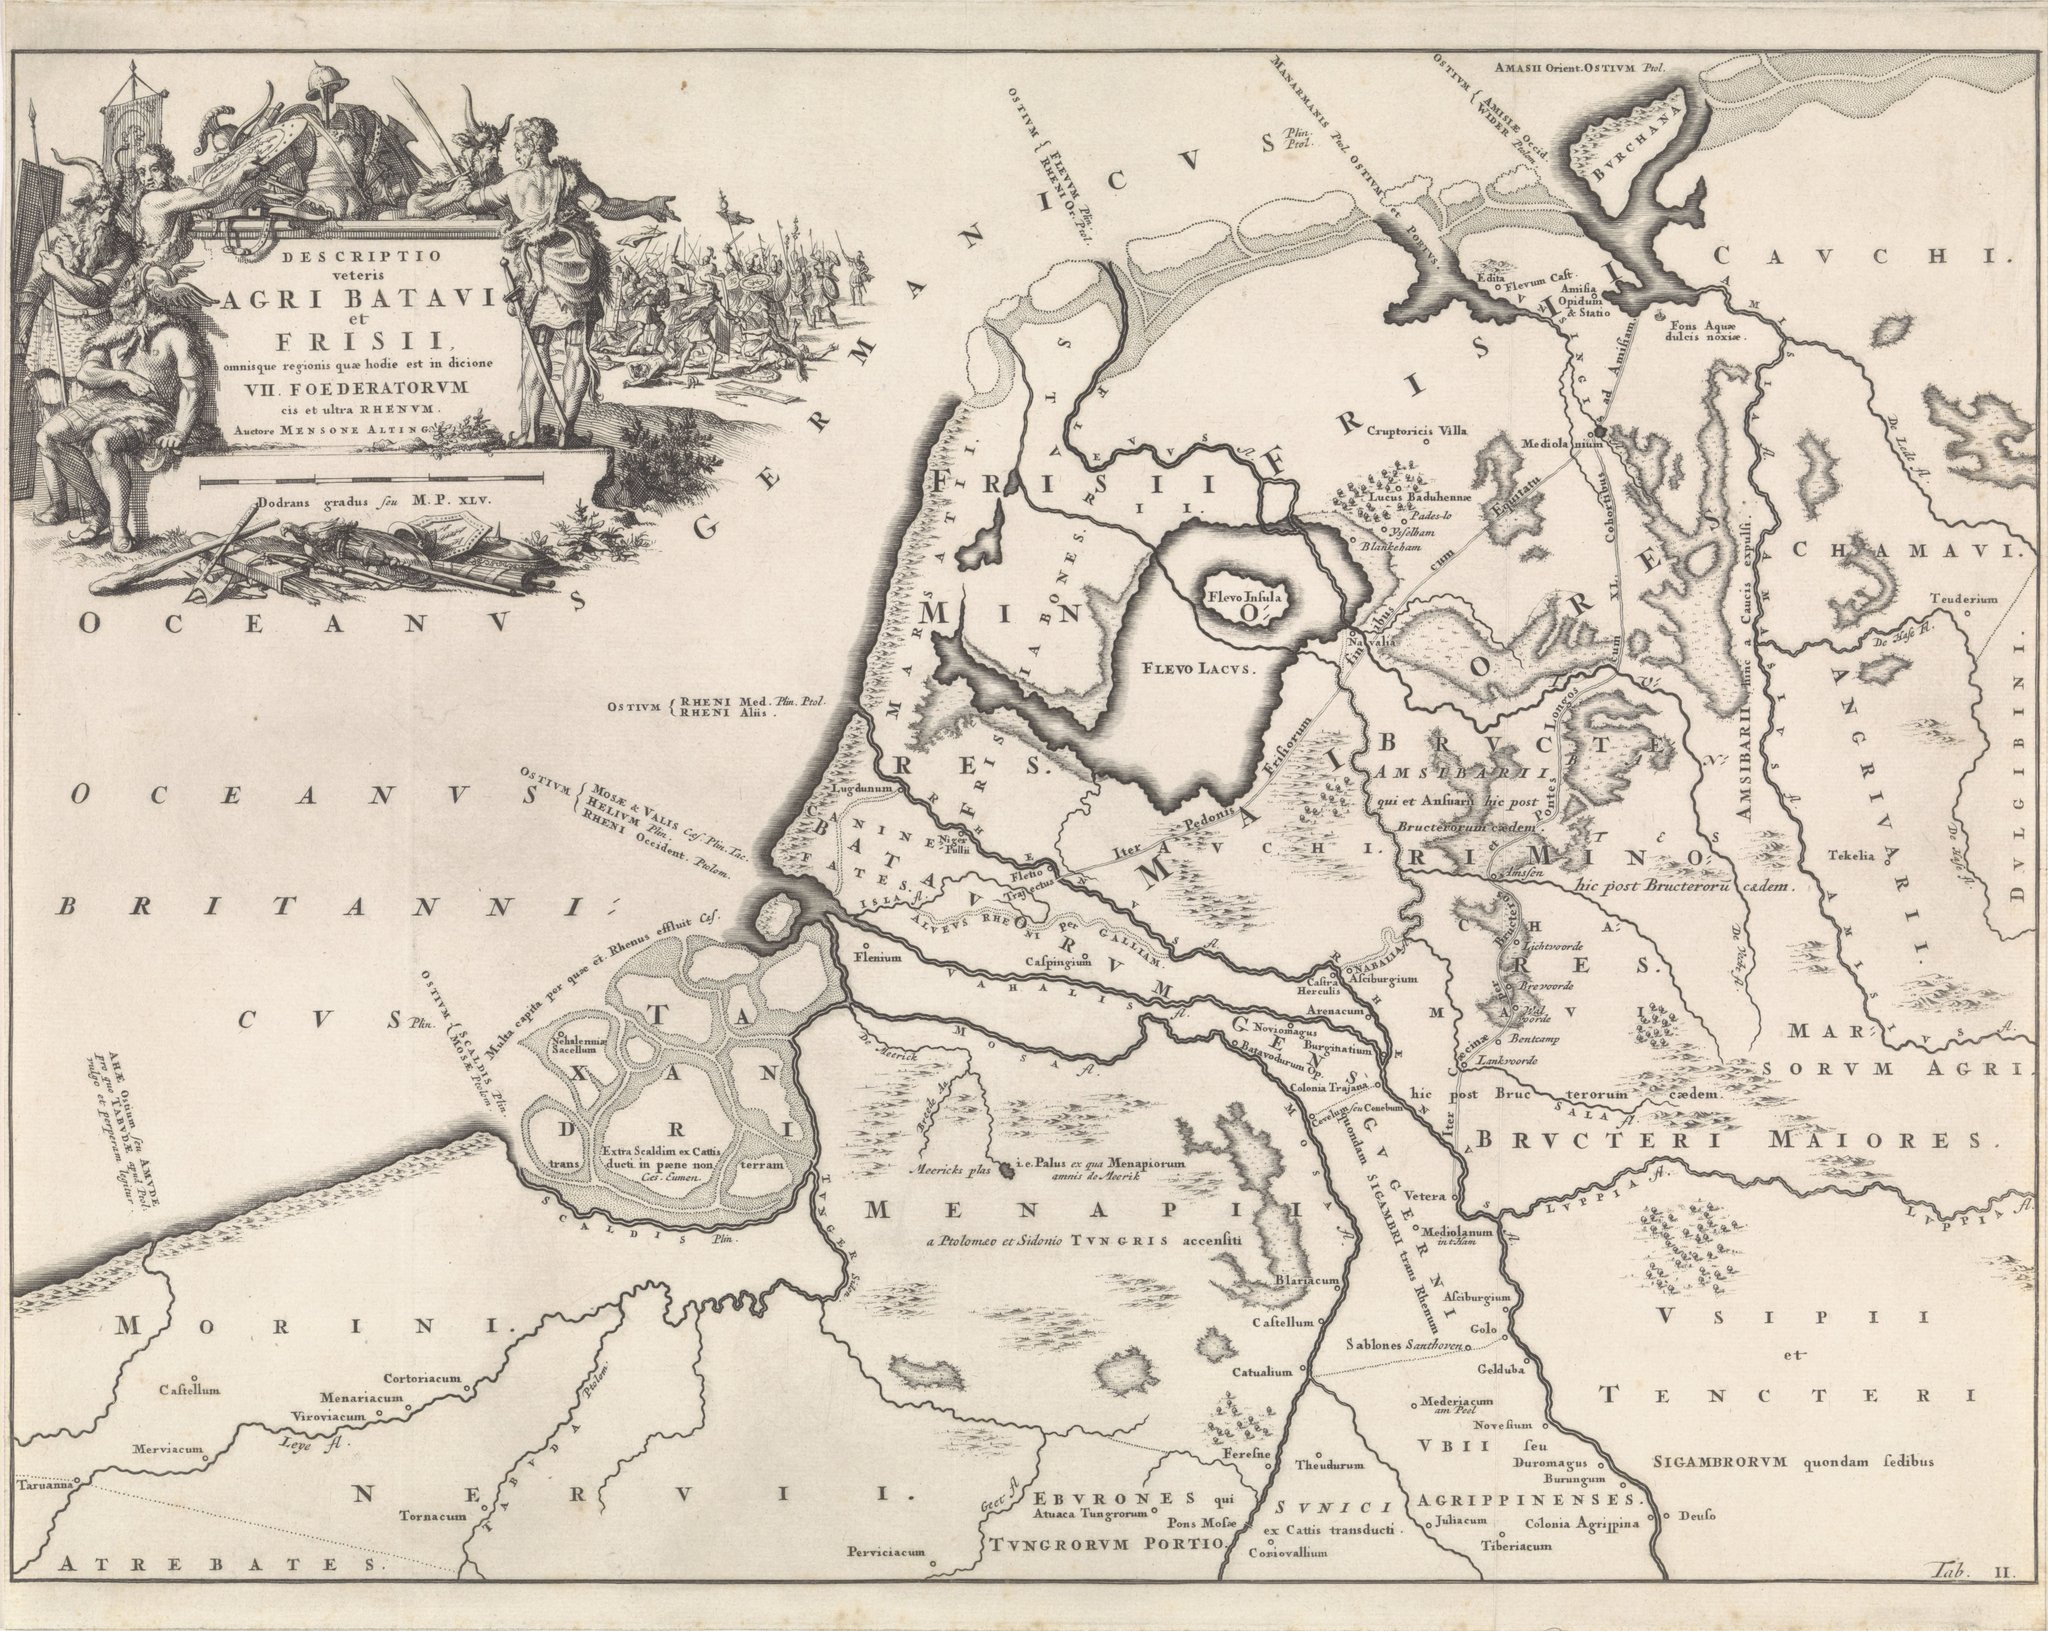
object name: book illustration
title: Historische kaart van Nederland ten tijde van de Bataven en de Friezen II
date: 1697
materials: paper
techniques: etching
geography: amsterdam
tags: maps of separate countries or regions, netherlands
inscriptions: collector's mark: Lugt 2228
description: Kaart afkomstig uit: Alting, Menso. Descriptio, secundum antiquos, agri Batavi & Frisii. 2 delen. Amsterdam: Henricus Wetstein, 1697, dl. I. Kaart hergebruikt in: Halma, François. Tooneel der Vereenigde Nederlanden en onderhorige landschappen, geopent in een algemeen historisch, genealogisch, geographisch en staatkundig woordenboek. 2 delen. Leeuwarden: Hendrik Halma, 1725. Volgens opschrift geplaatst in: deel 1, pag. 1c.